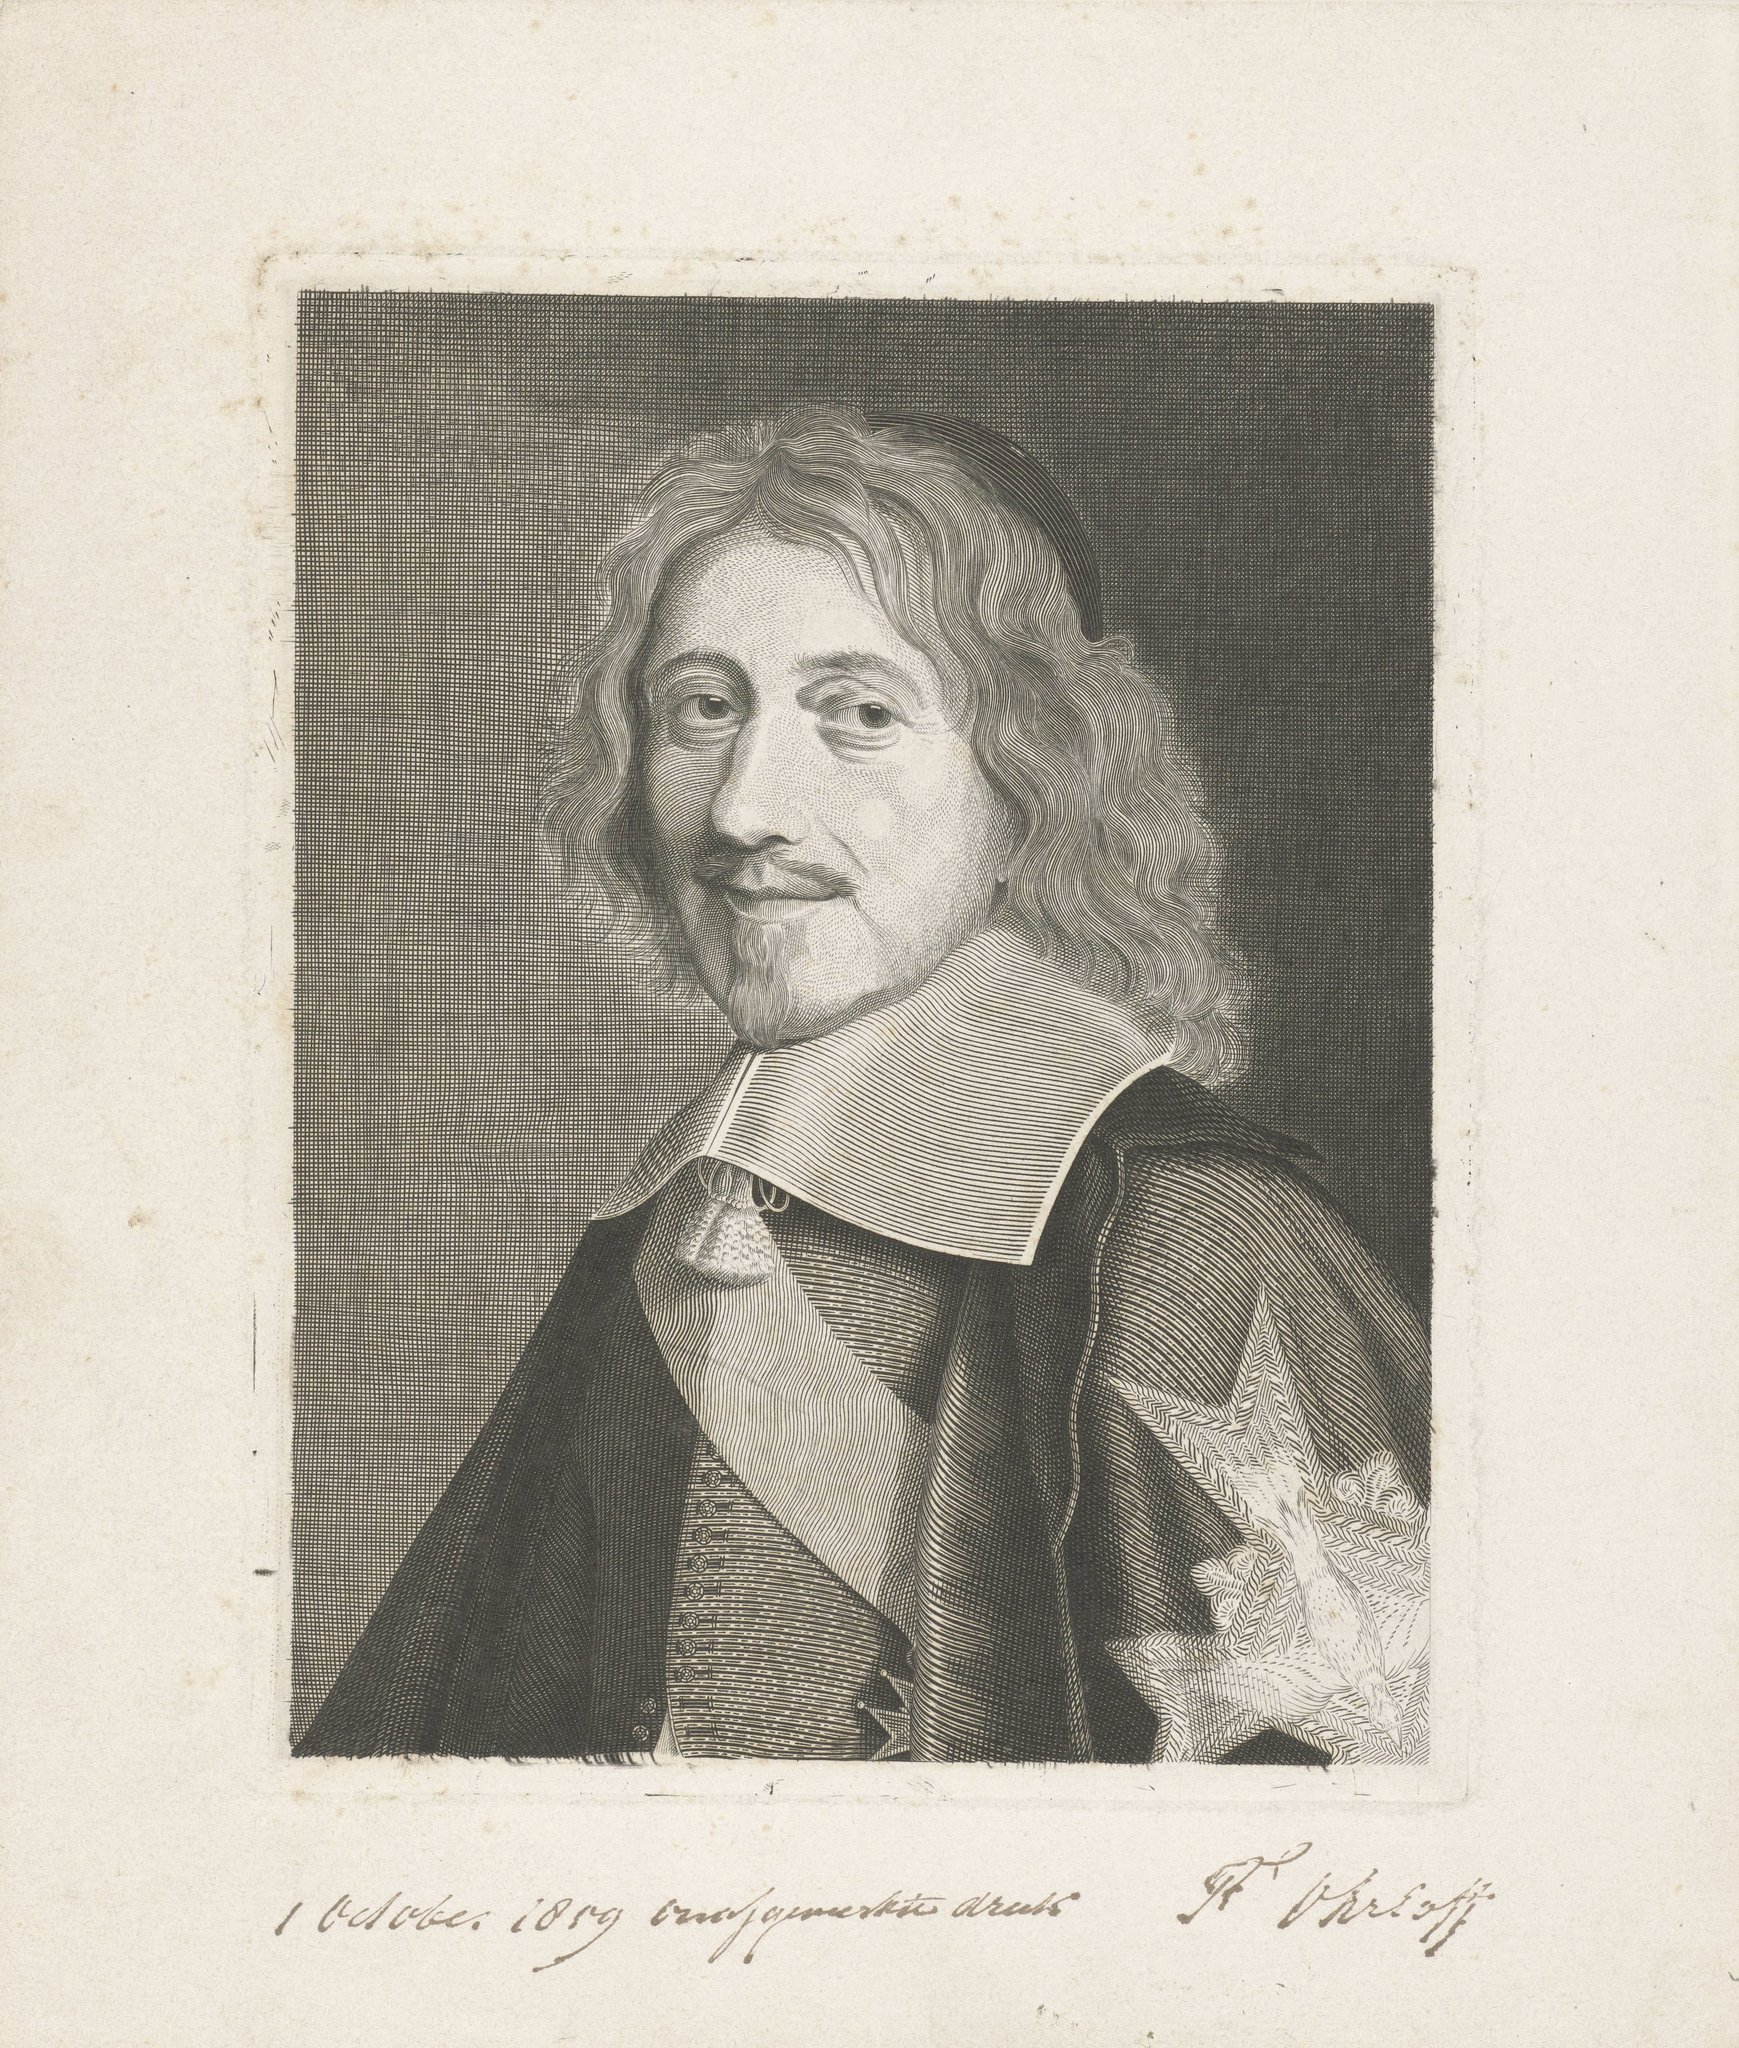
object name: print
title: Portret van kanselier Michel Le Tellier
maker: frits ohrloff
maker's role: print maker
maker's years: 1837-1883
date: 1859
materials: paper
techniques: engraving, etching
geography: amsterdam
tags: paris, michel le tellier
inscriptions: collector's mark: Lugt 2228, inscription: ‘1 October 1859 onafgemaakte druk F. Ohrloff’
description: Portret van de Franse kanselier Michel Le Tellier. Op zijn mouw is het kruis van de Orde van de Heilige Geest geborduurd.